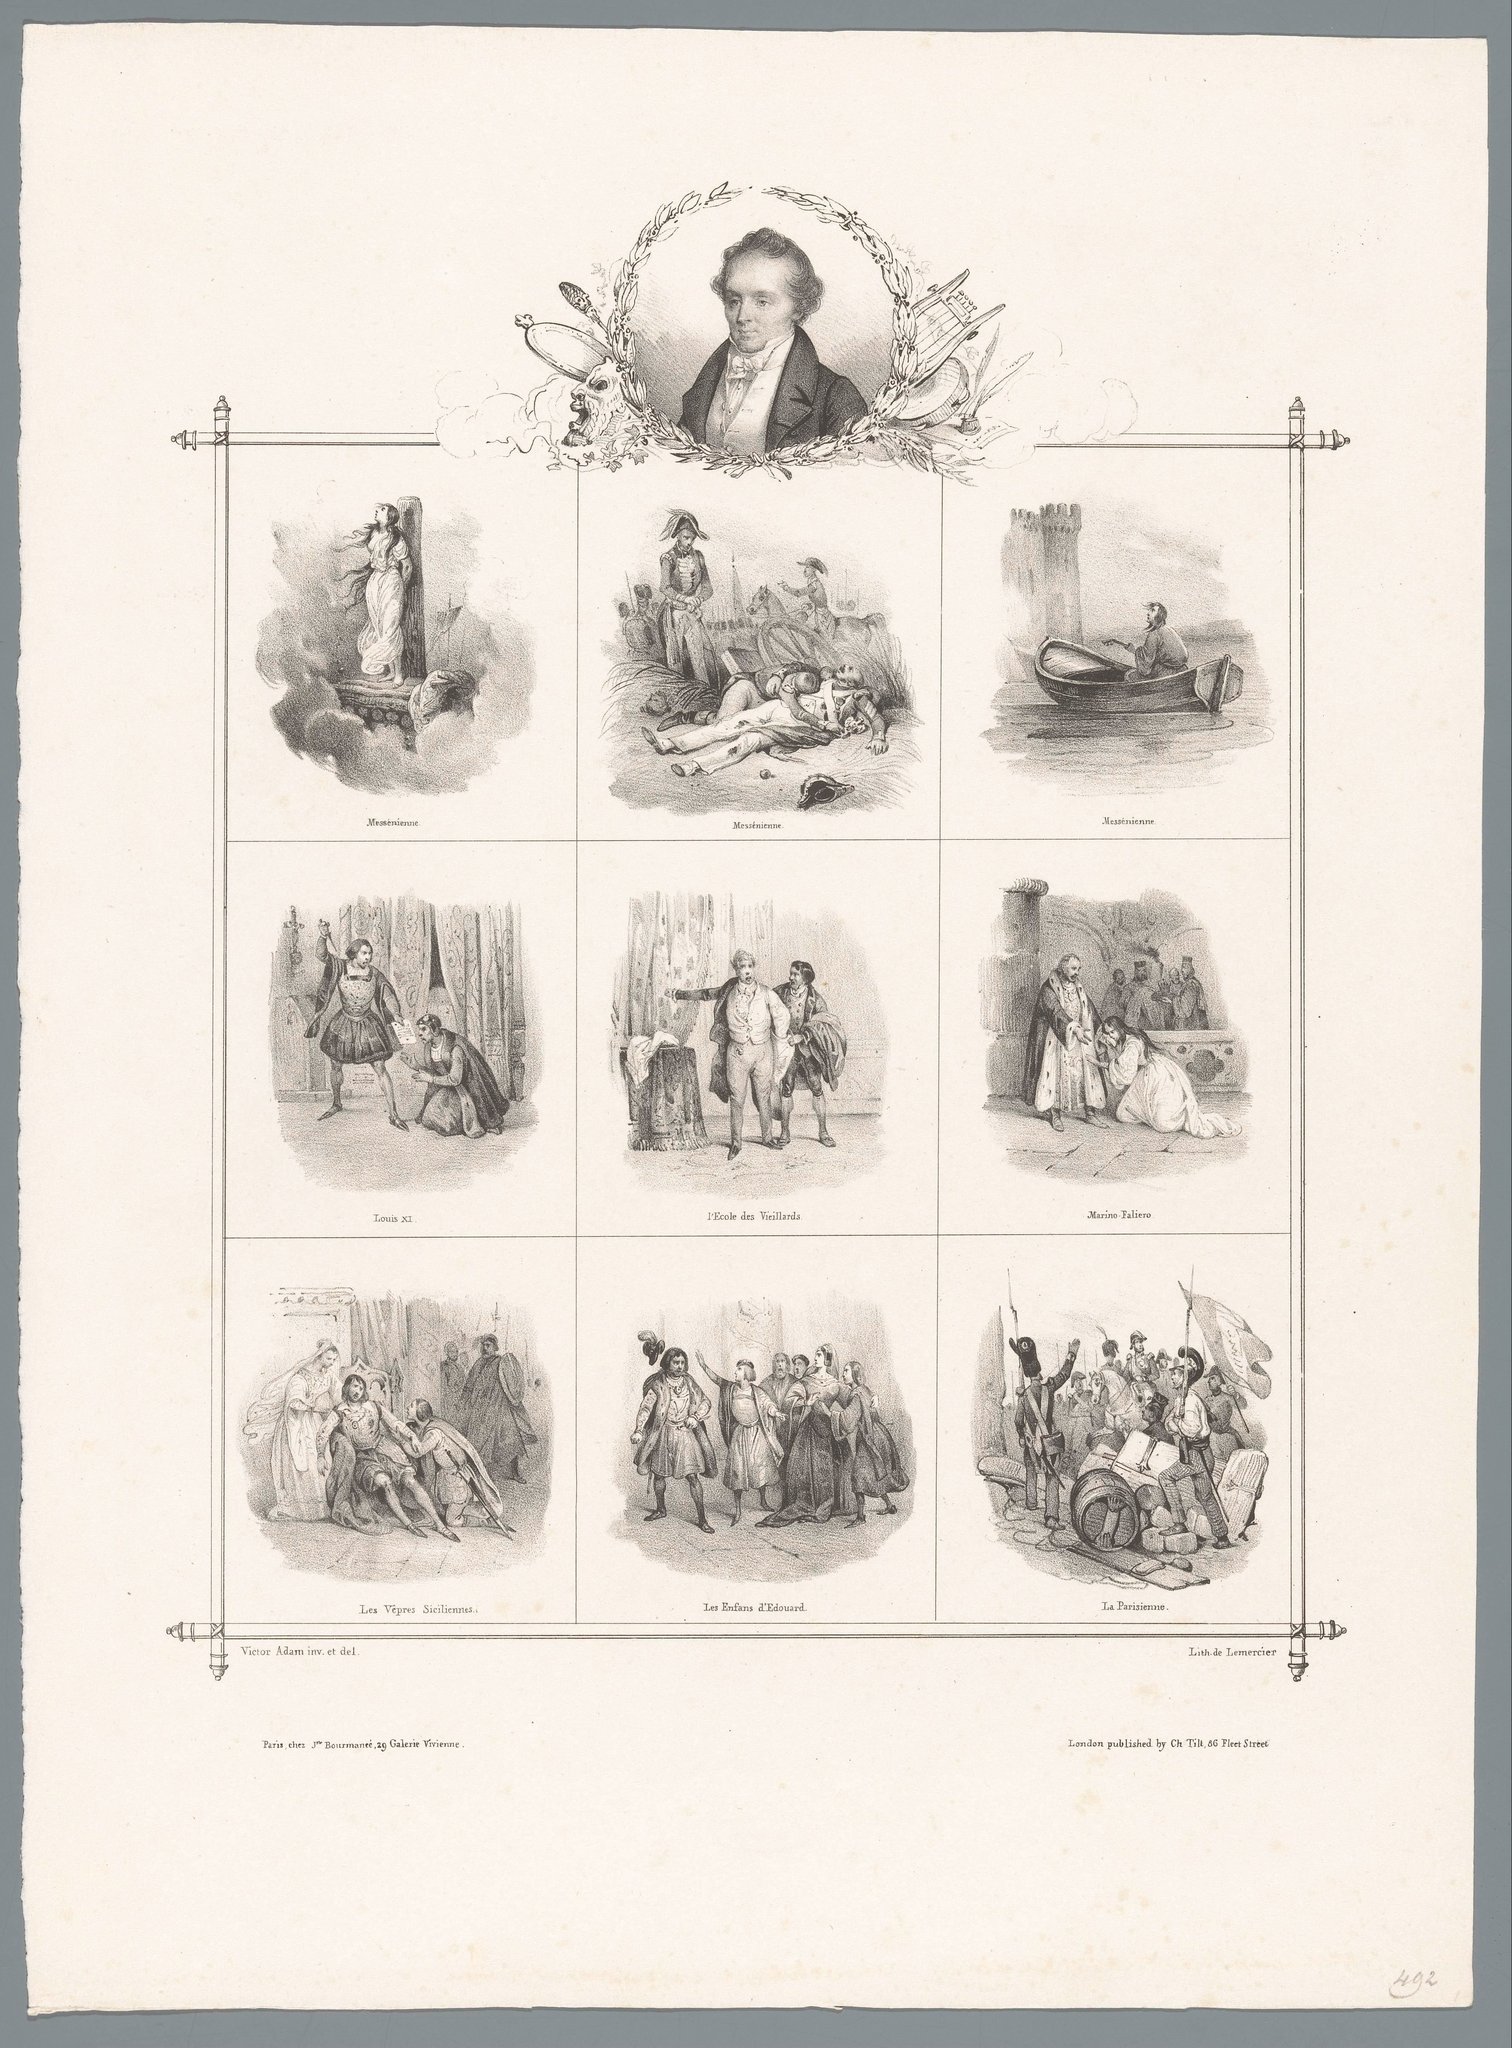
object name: print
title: Portraits d'écrivains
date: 1835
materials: paper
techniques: lithograph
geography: paris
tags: historical persons, portrait of a writer, (scenes from) specific works of literature (with author, title)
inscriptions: collector's mark: Lugt 2228, number: ‘492’